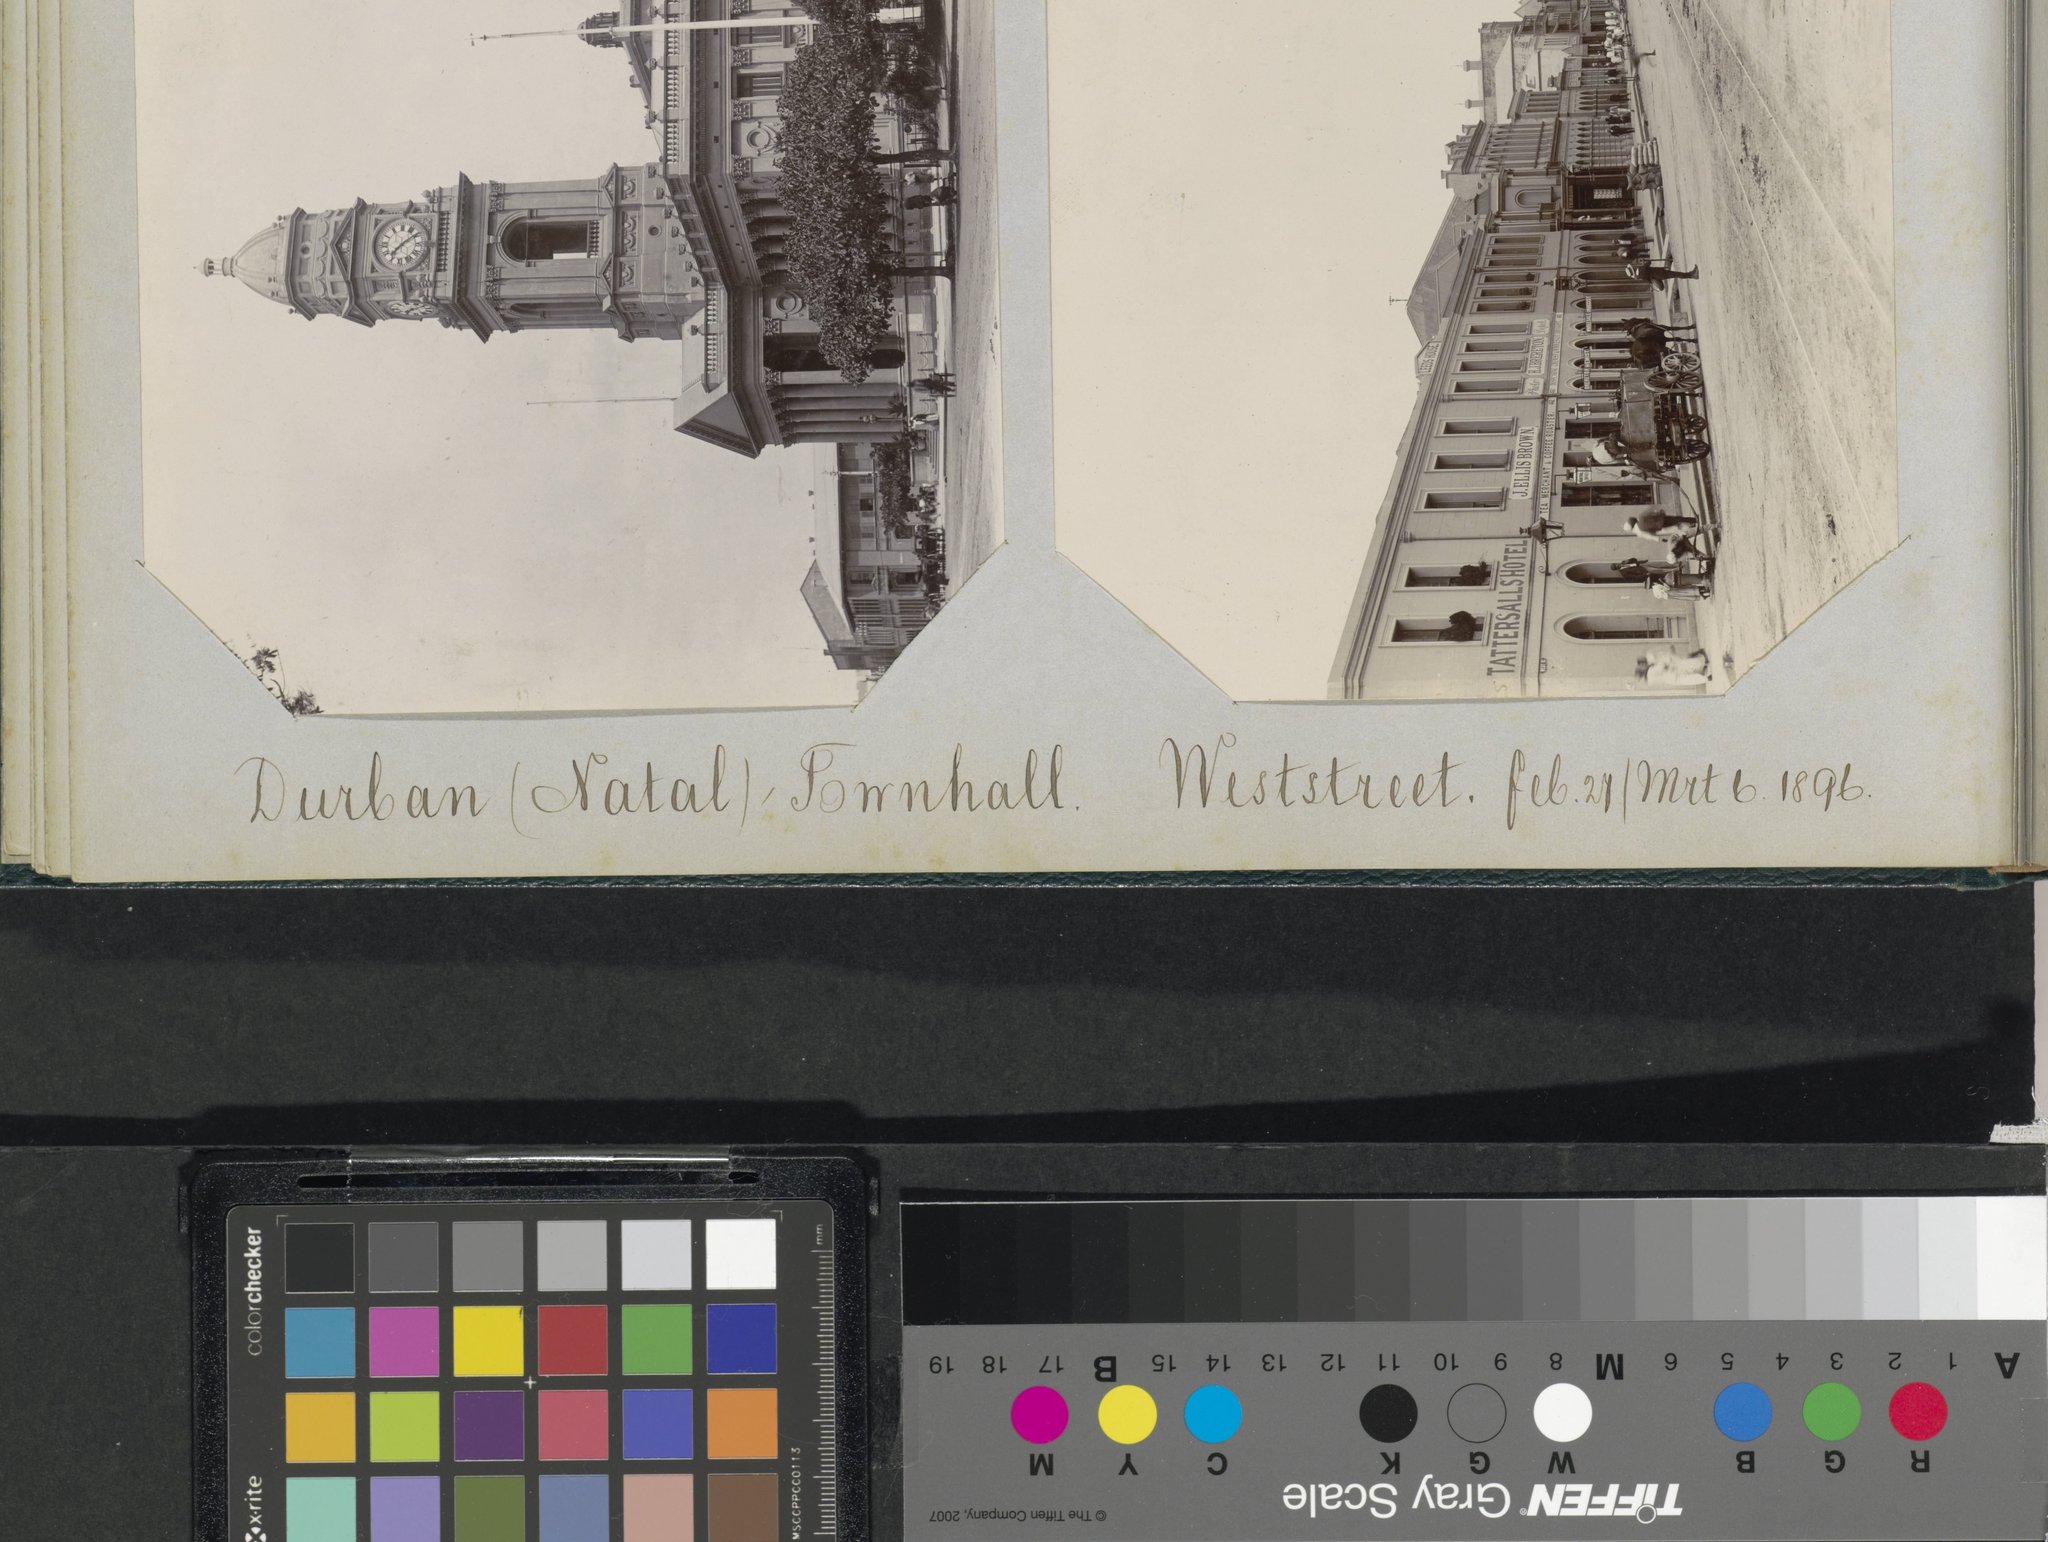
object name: album leaf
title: Gezicht op Weststreet te Durban, Zuid-Afrika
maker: t.o. oole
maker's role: fotograaf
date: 1896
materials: photographic support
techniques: gelatin silver print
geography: durban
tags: street (+ city(-scape) with figures, staffage)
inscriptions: inscription: ‘[T. OoLe] Photo, Durban’